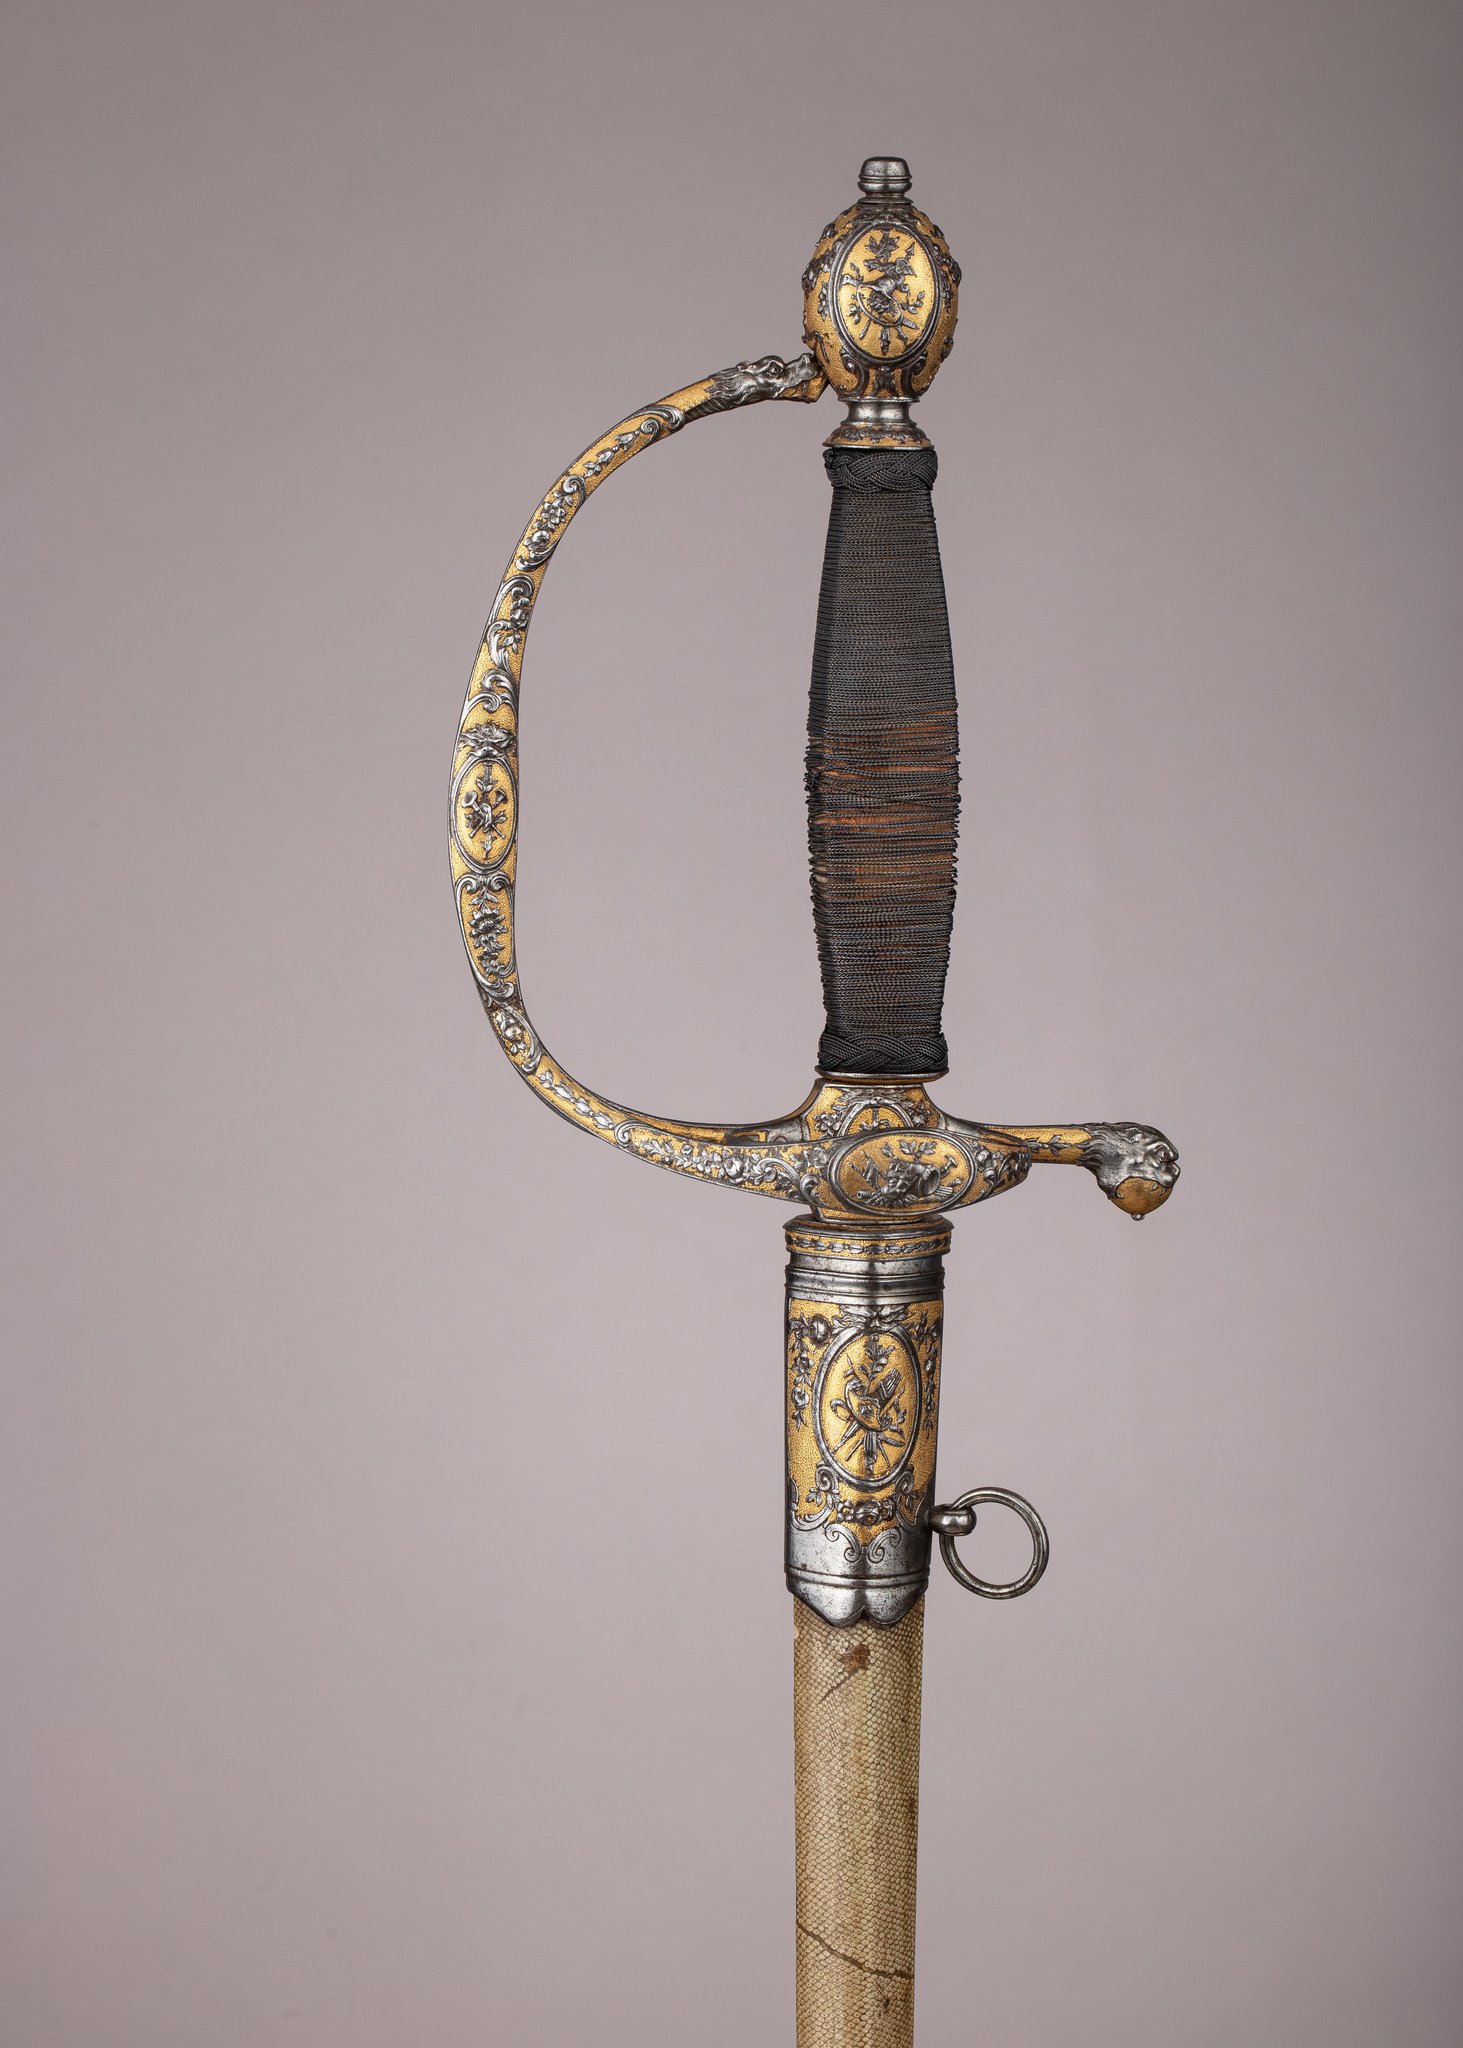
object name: smallsword with scabbard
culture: french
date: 1785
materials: gold, skin, steel, wood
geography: france